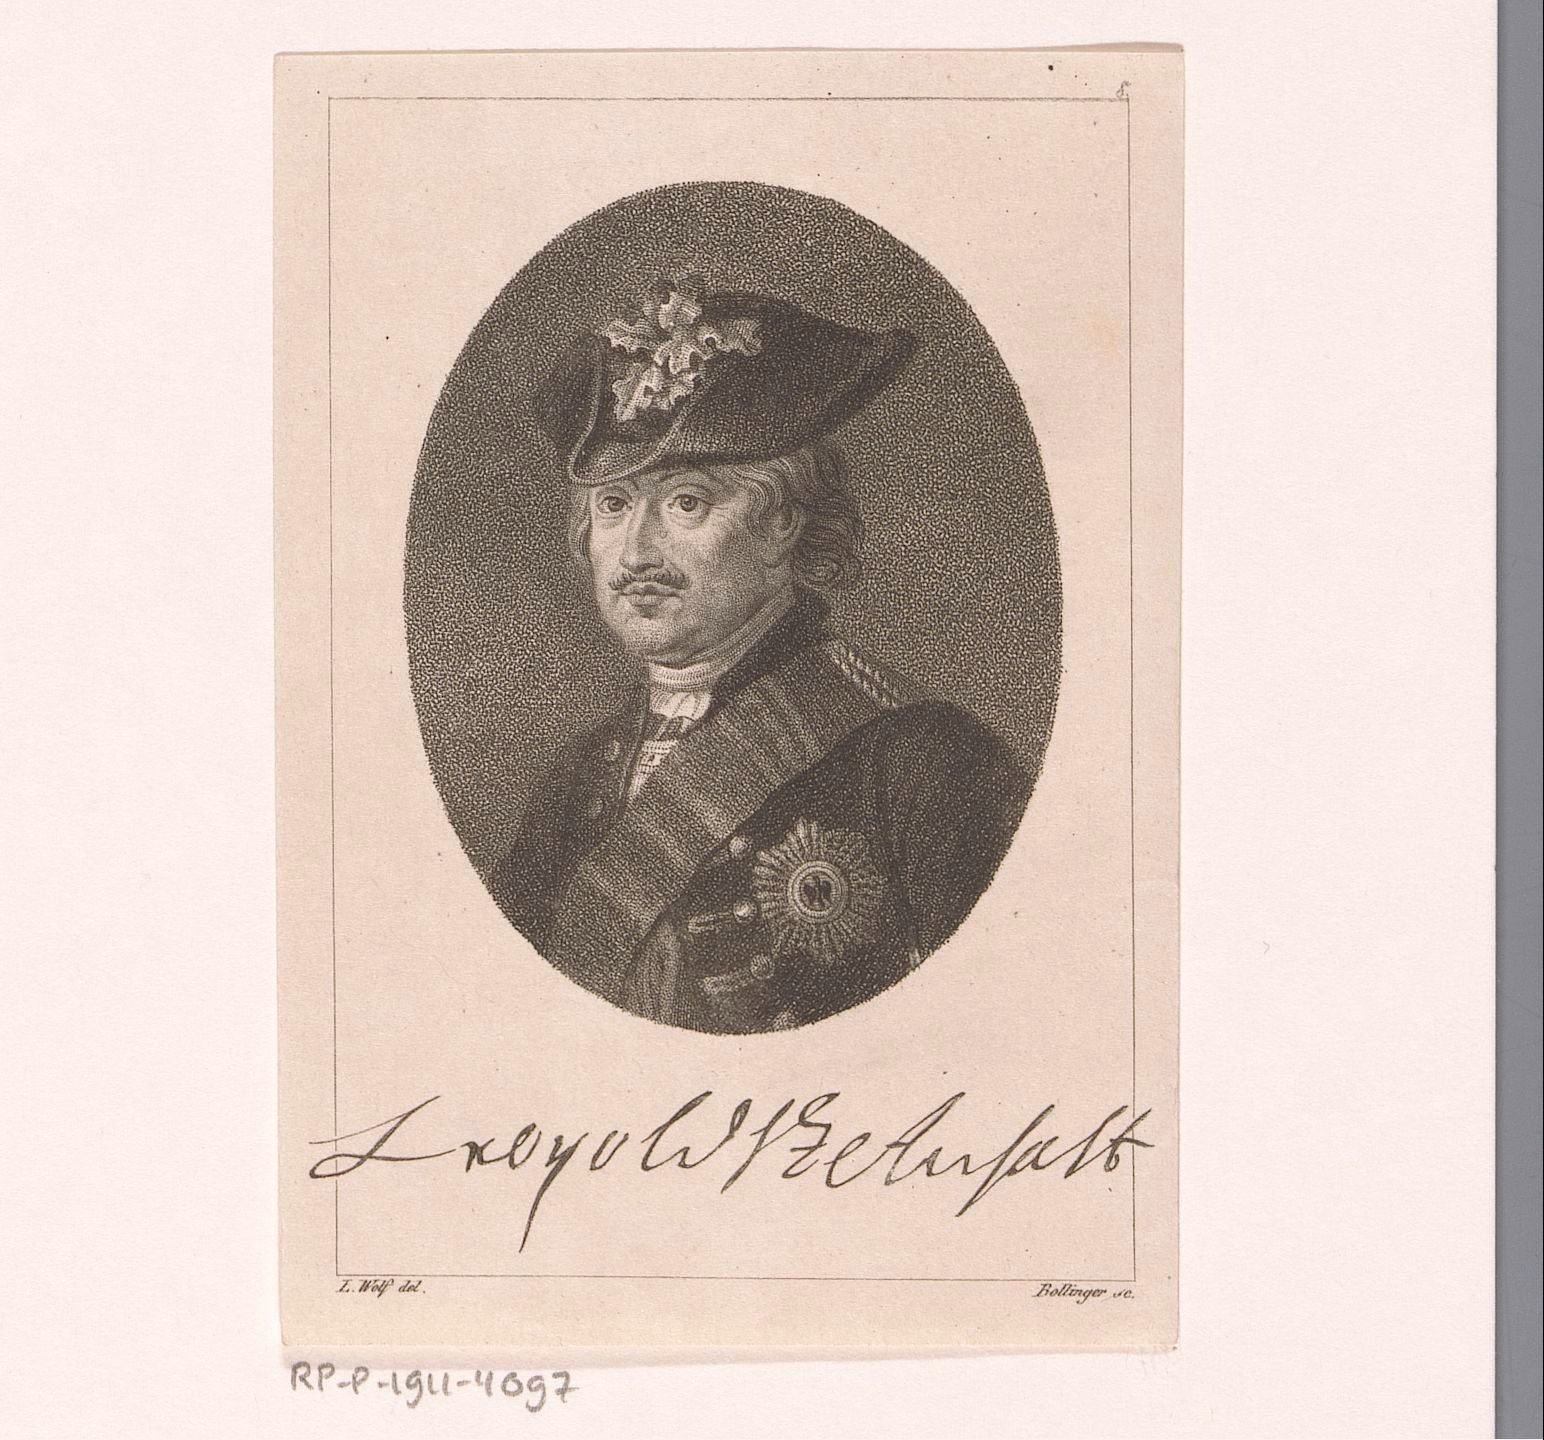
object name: print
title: Portret van Leopold I van Anhalt-Dessau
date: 1787-1825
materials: paper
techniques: stippling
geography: berlin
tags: knighthood order (with name) - insignia of a knighthood order, e.g.: badge, chain (with name of order), historical persons, (military) uniforms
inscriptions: collector's mark: Lugt 2228